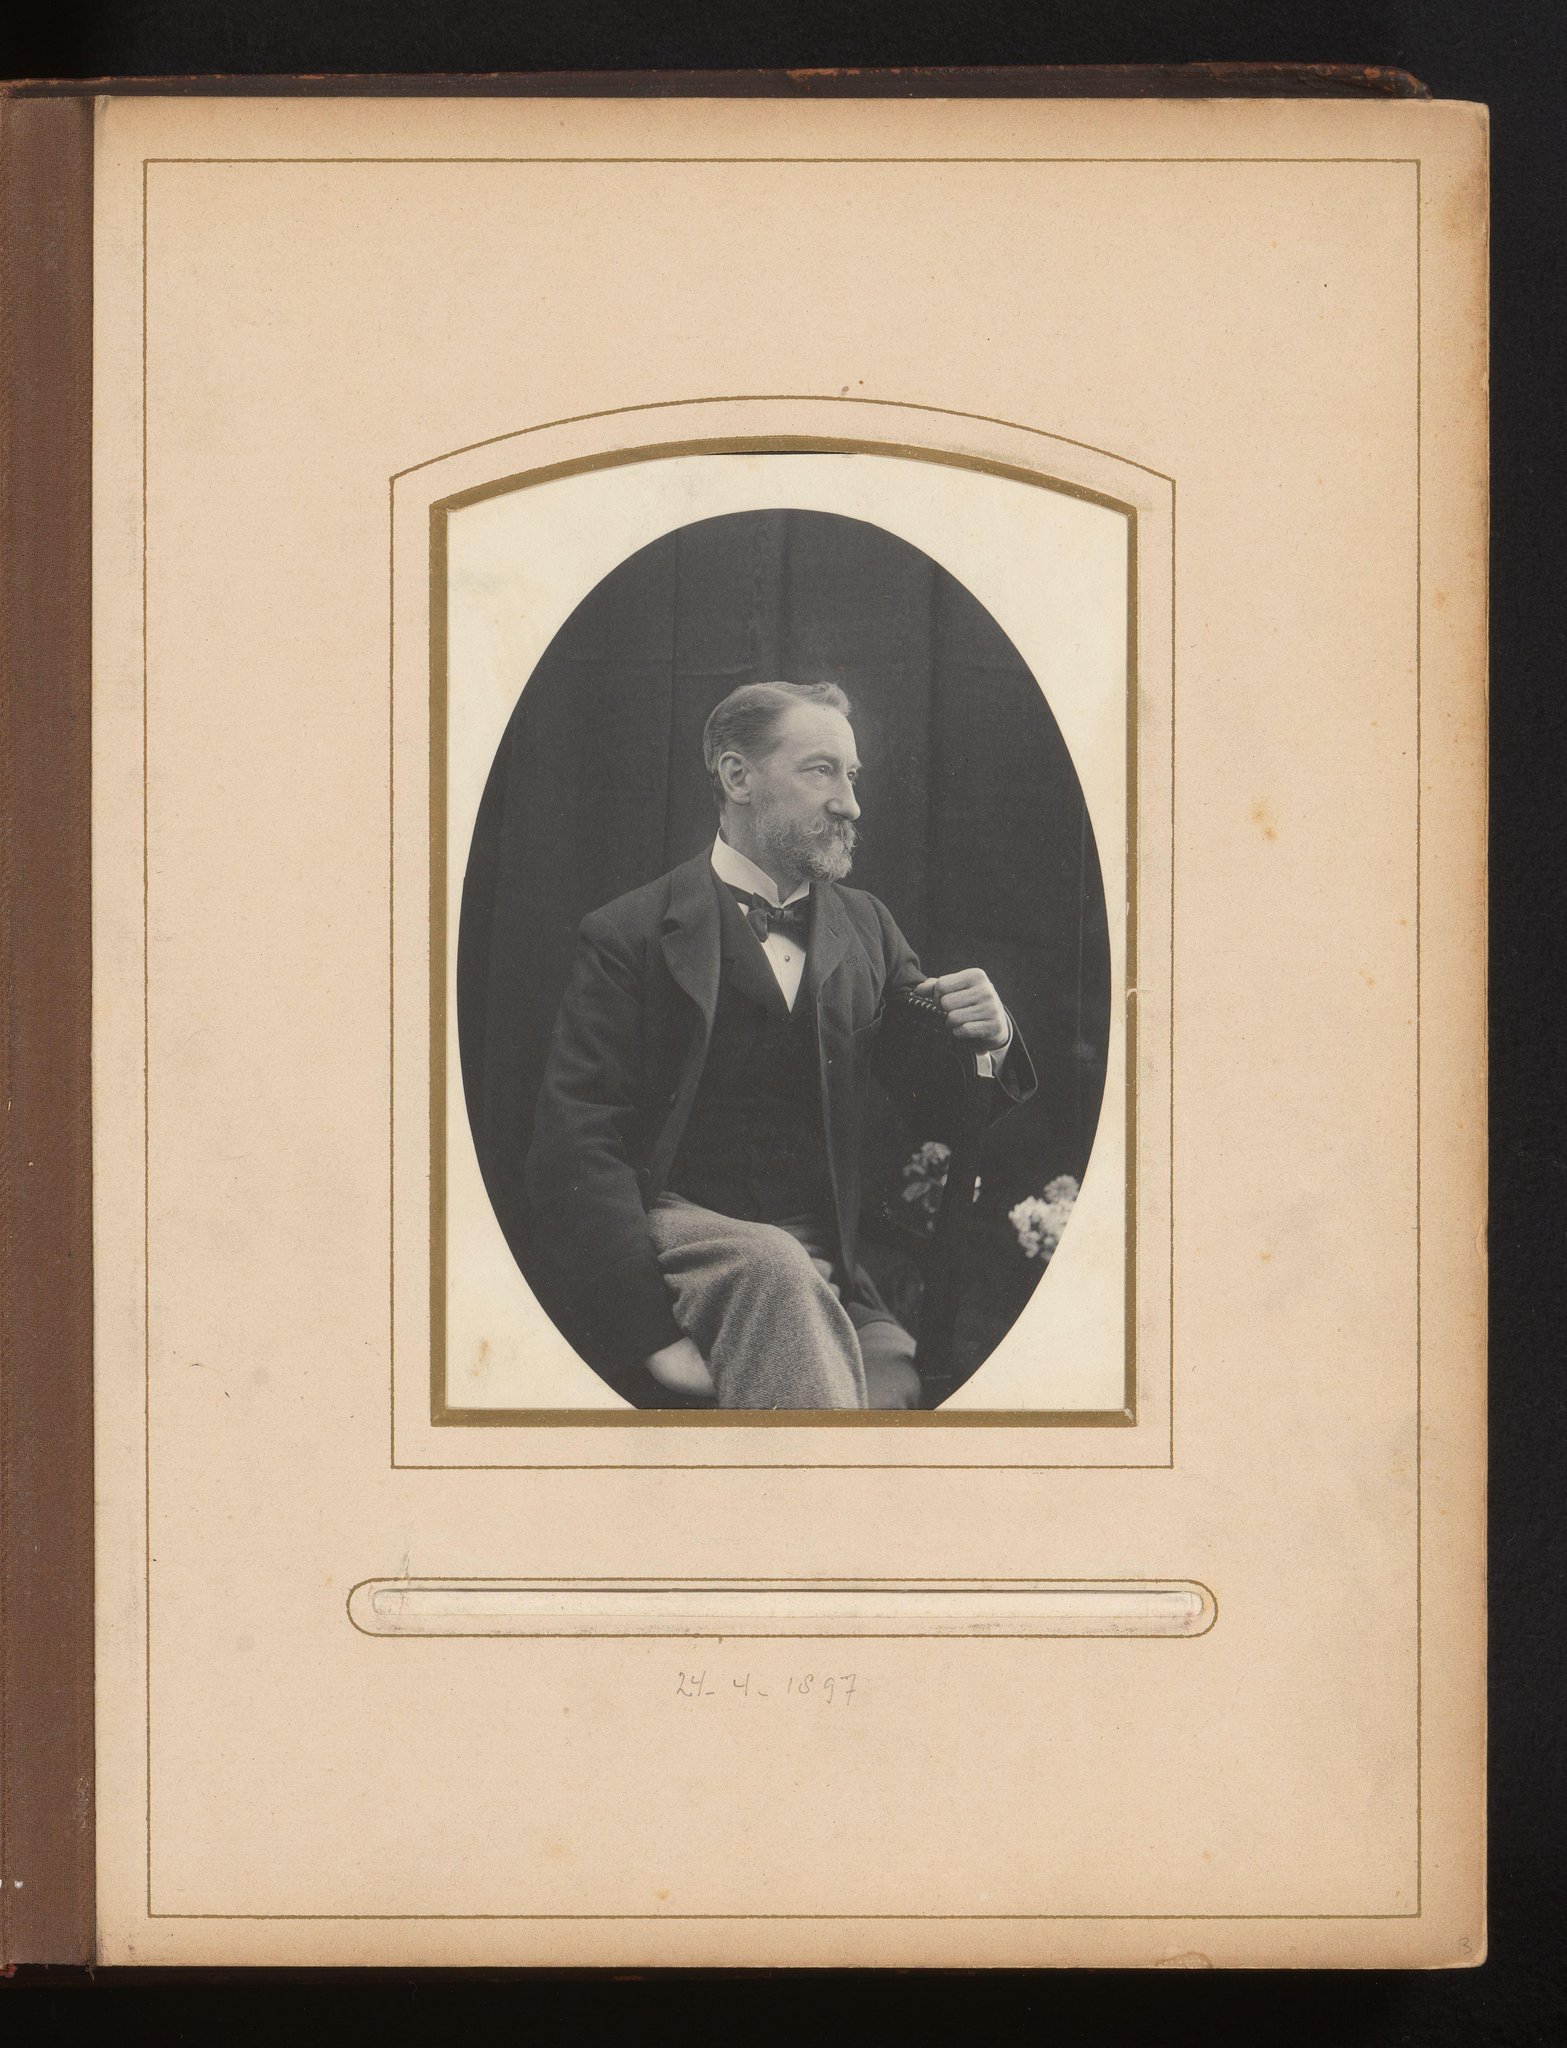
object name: photograph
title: Portret van een man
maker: Anonymous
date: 1897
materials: cardboard, photographic support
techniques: platinum process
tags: sitting figure, adult man, historical persons, beard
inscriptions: annotation: ‘J.H. 24/4/97’